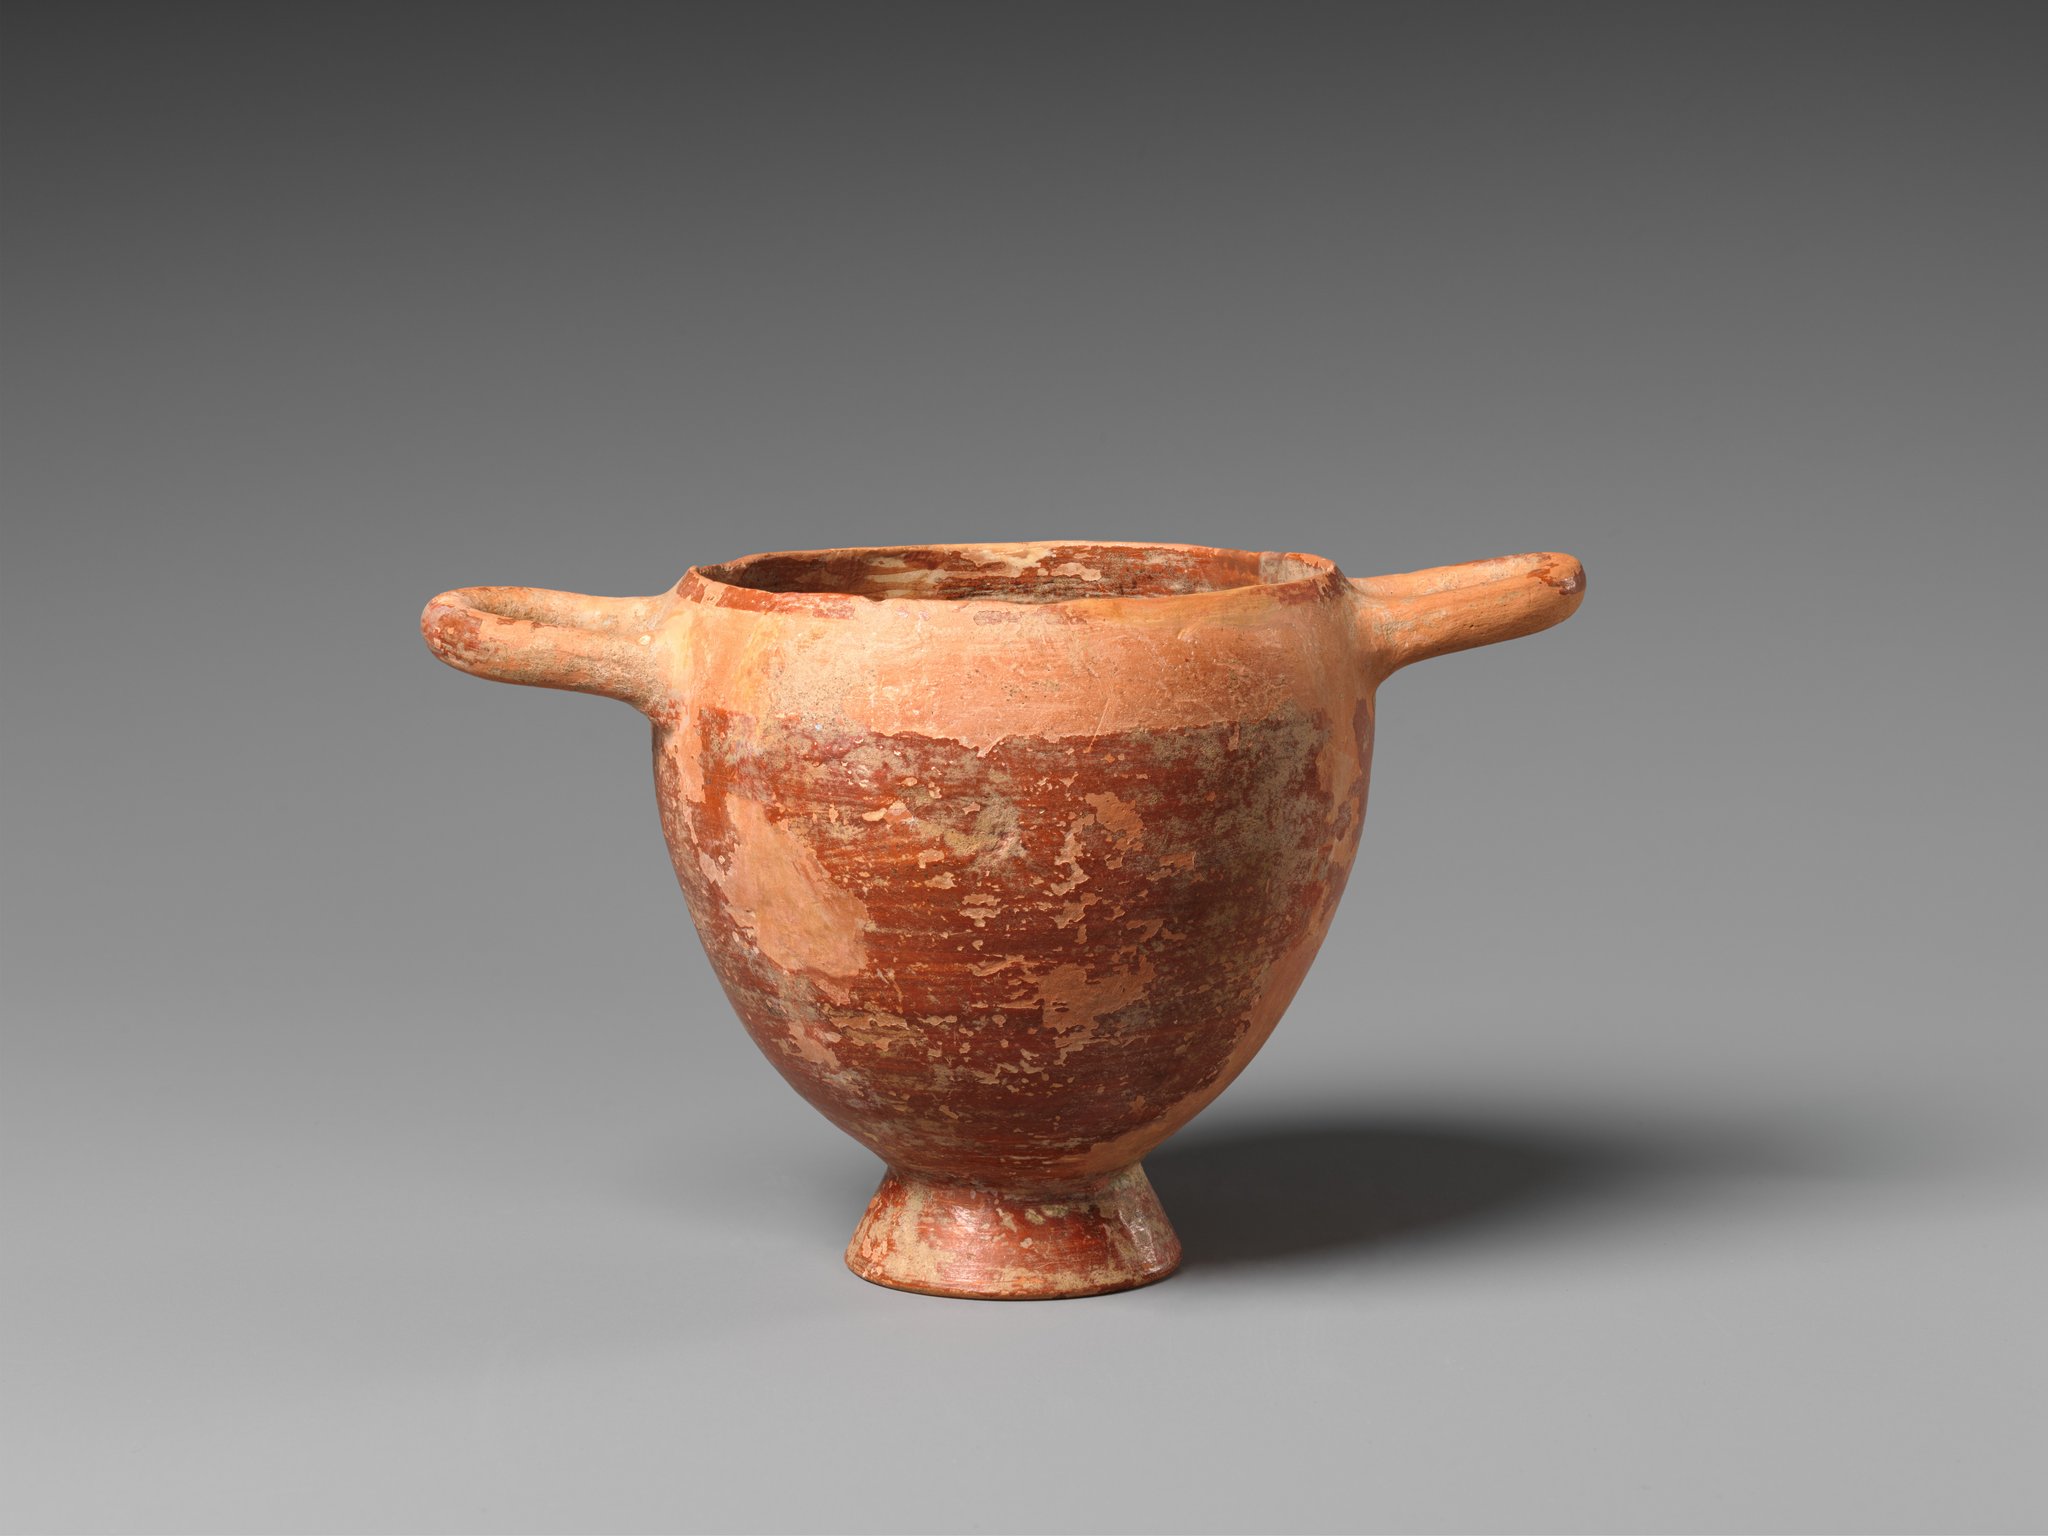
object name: skyphos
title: Terracotta skyphos (drinking cup)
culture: lydian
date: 700-501 BCE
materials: terracotta